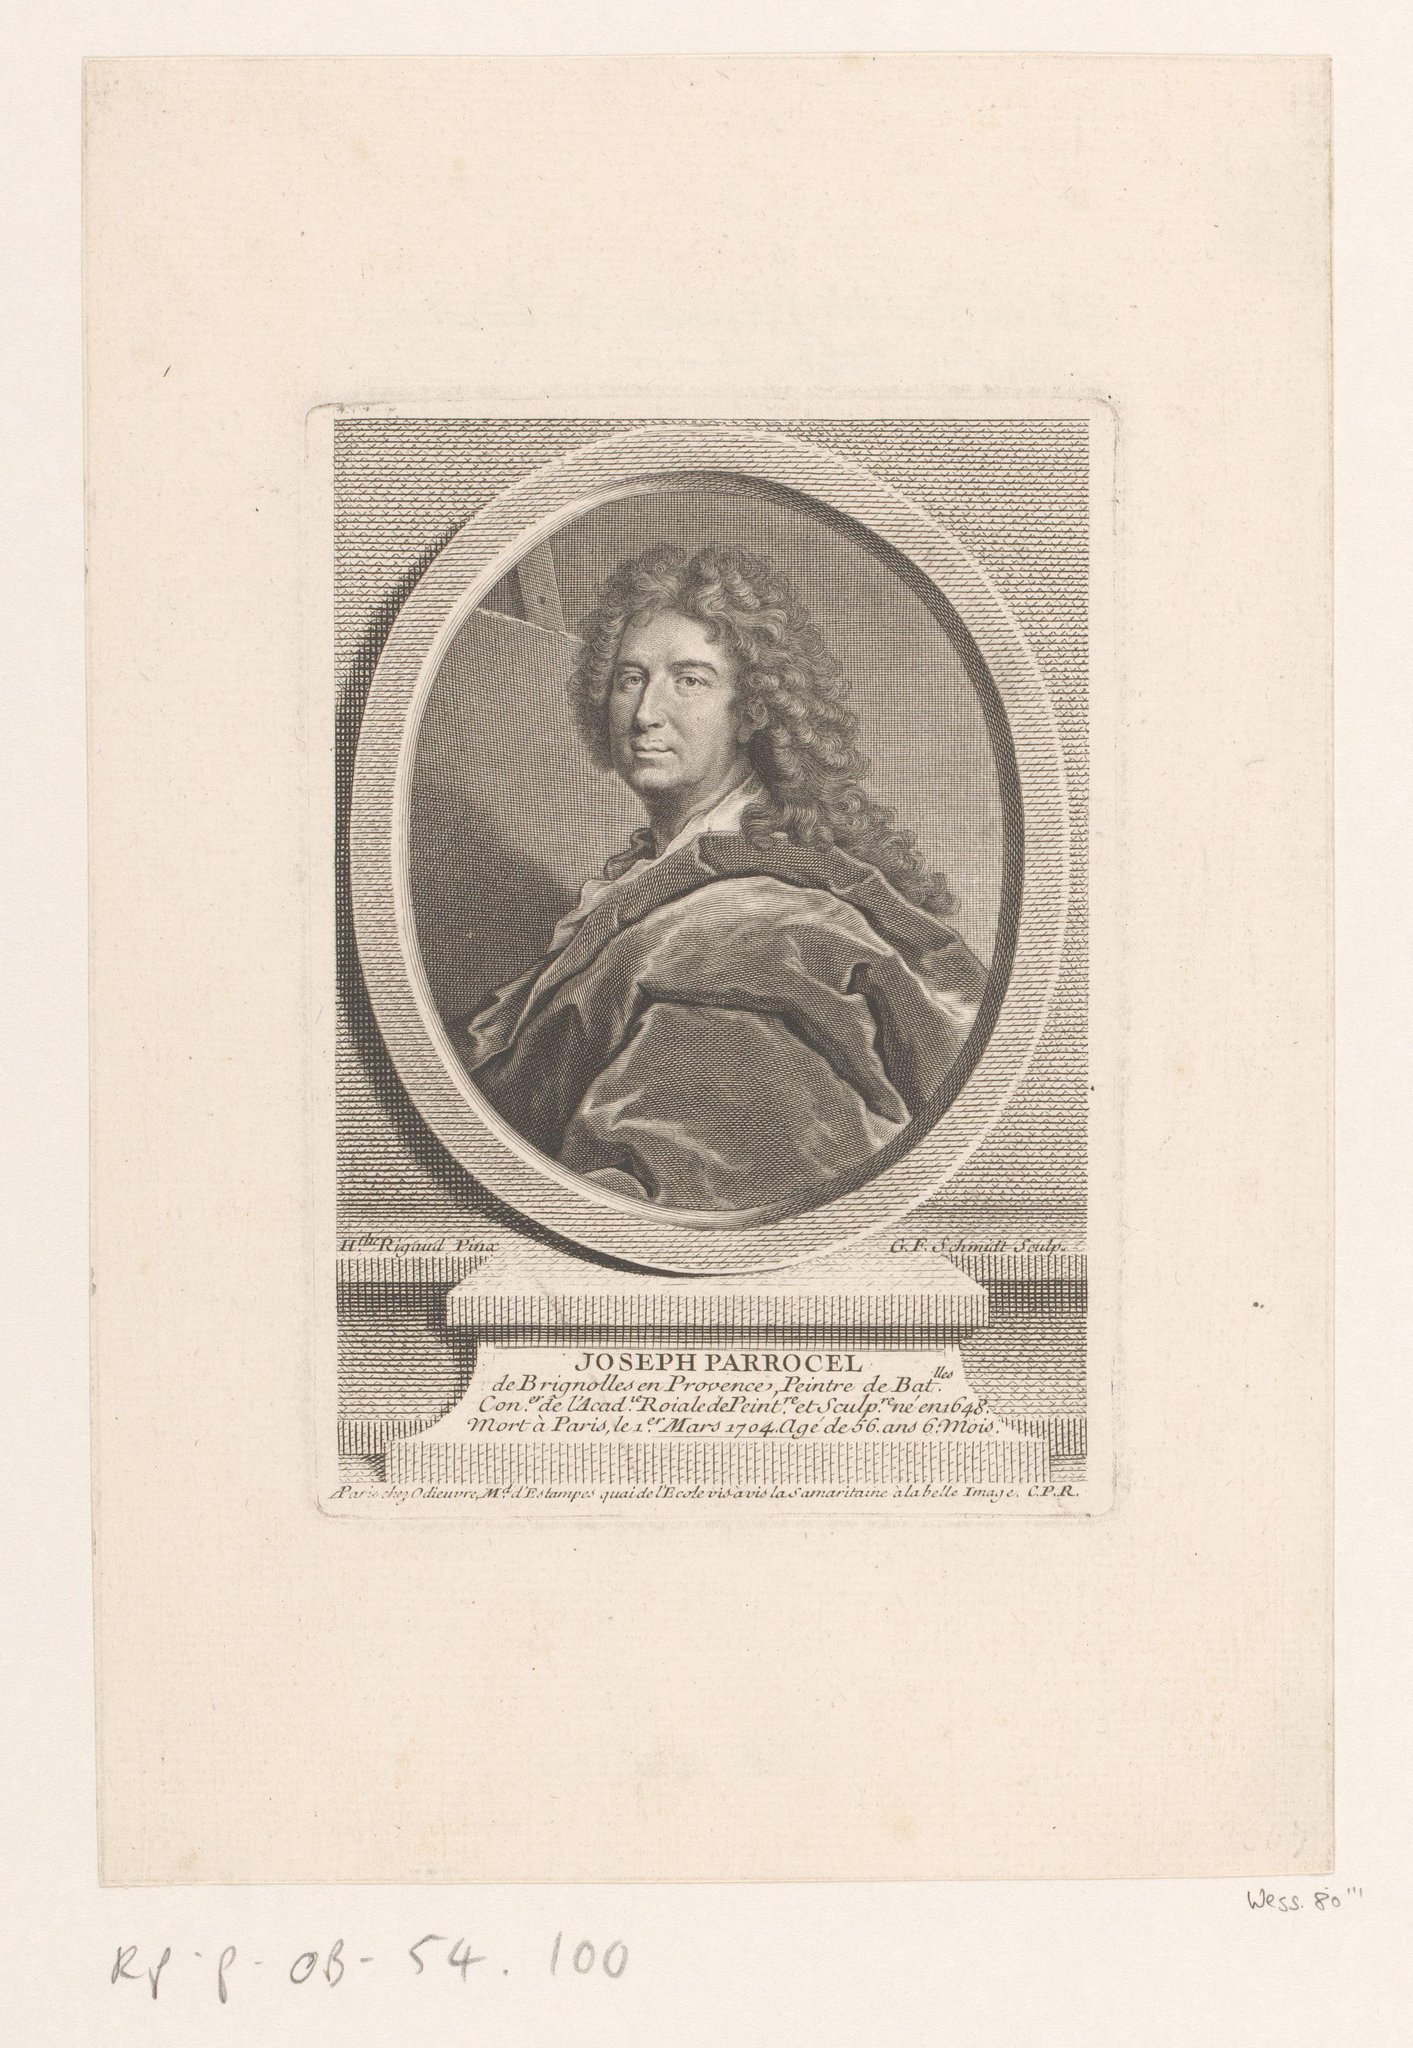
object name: print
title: Portret van Joseph Parrocel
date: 1737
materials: paper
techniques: engraving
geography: paris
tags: paris, print maker, joseph parrocel, historical persons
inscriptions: collector's mark: Lugt 240